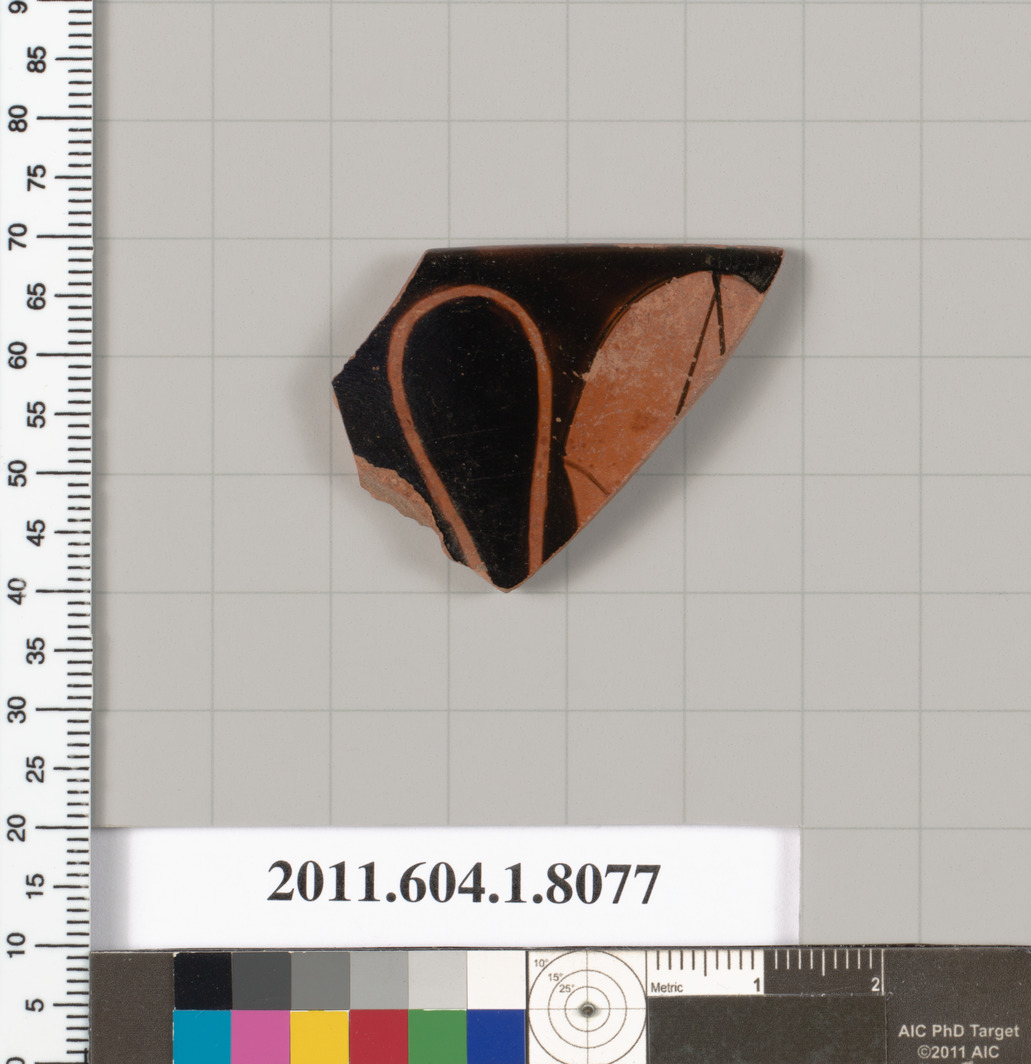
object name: kylix fragment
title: Terracotta rim fragment of a kylix (drinking cup)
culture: greek, attic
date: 525-501 BCE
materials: terracotta